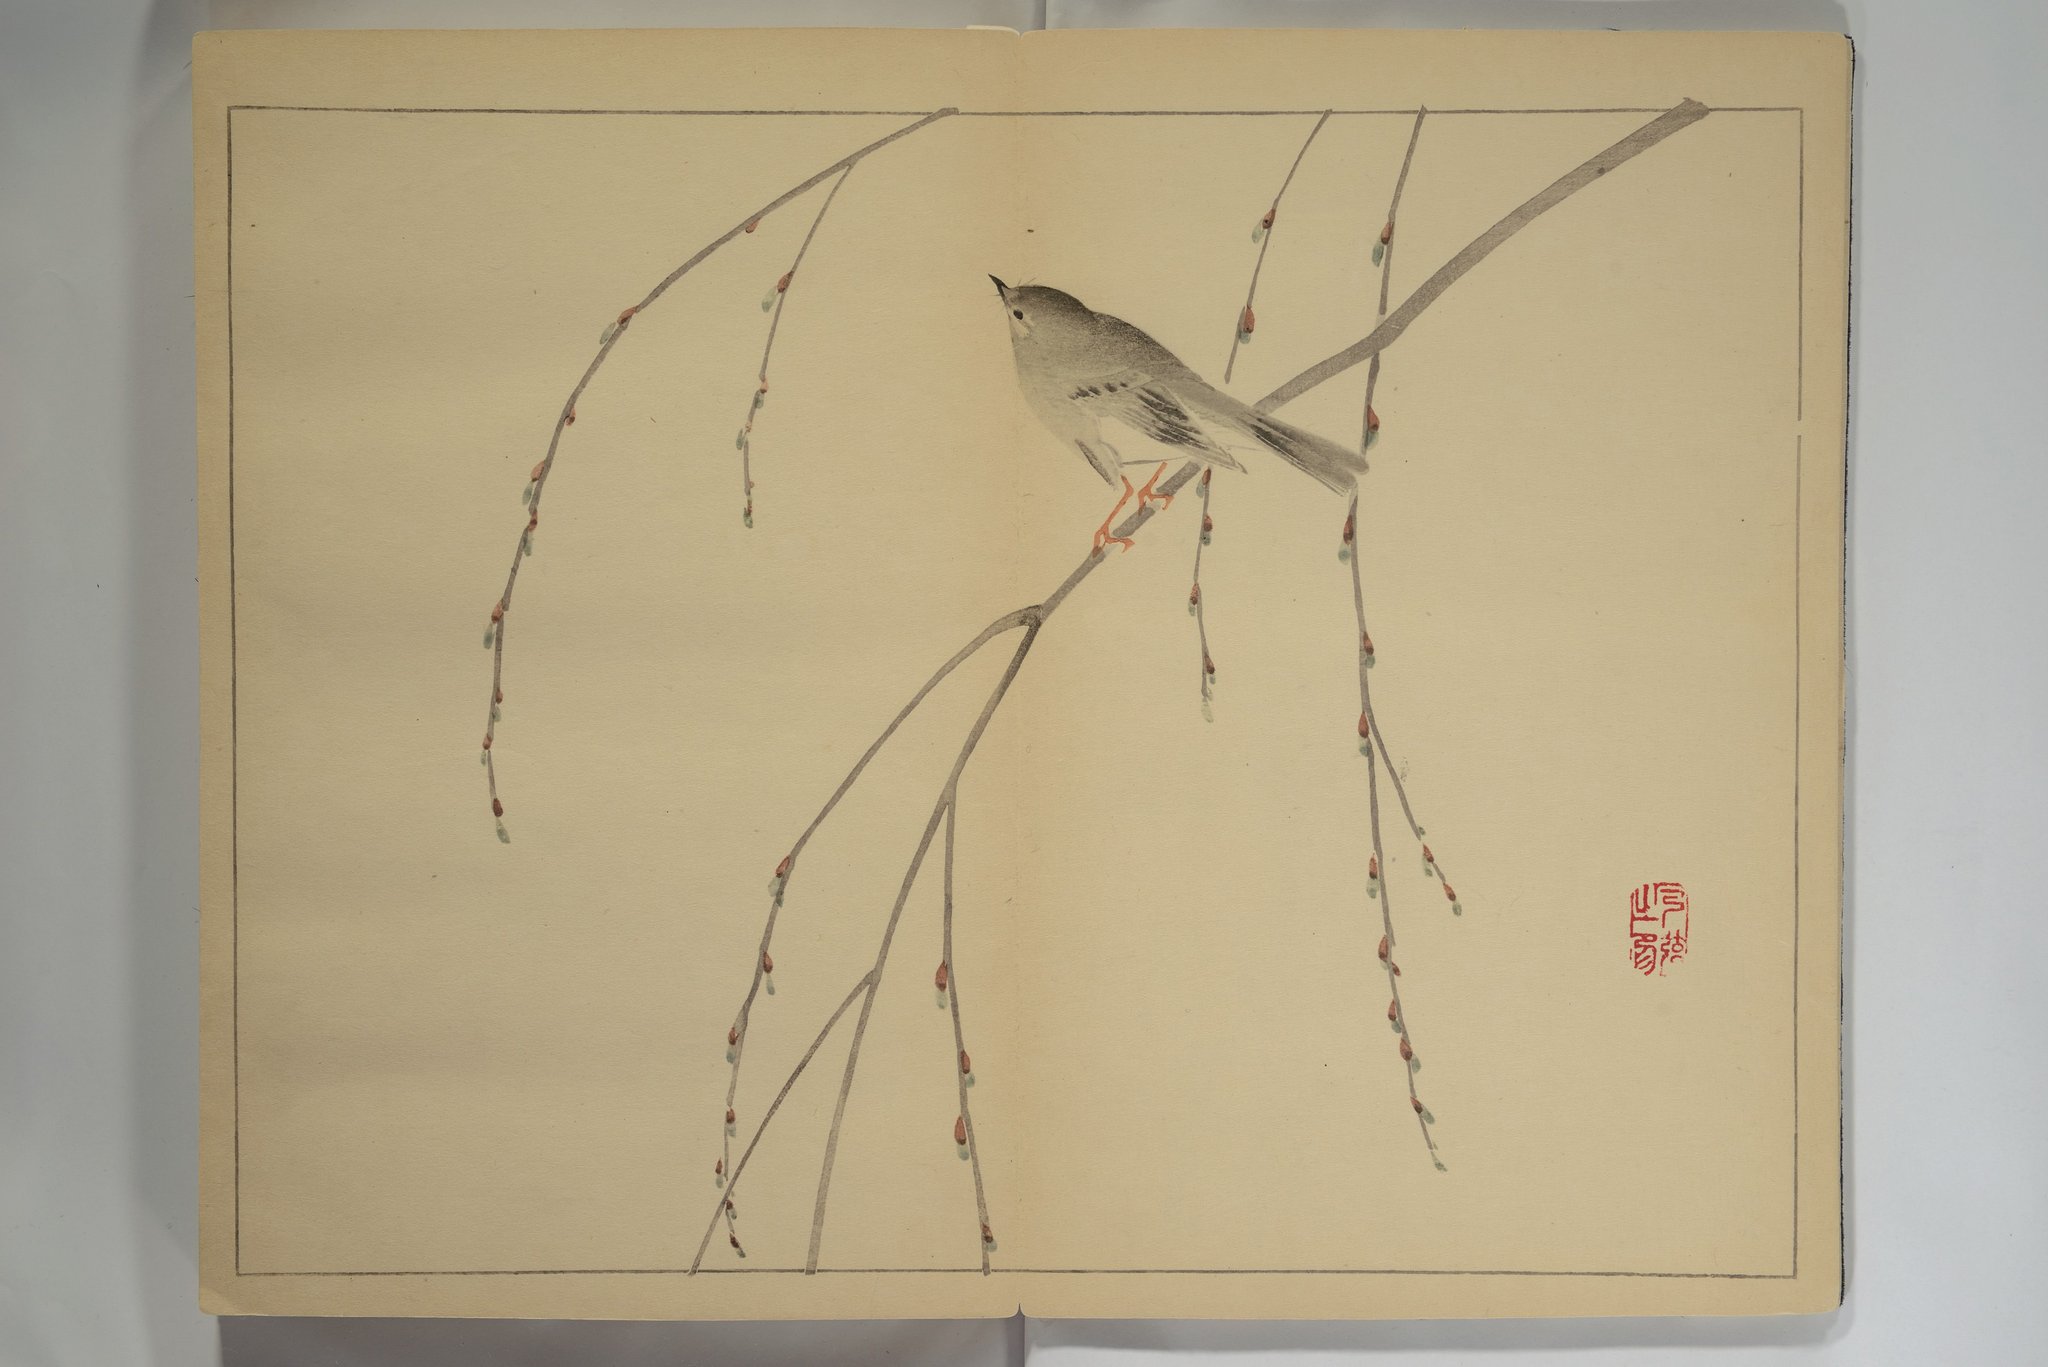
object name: illustrated book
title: Kan'ei Picture Album (Kan'ei gafu 完瑛画譜)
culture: japanese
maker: nishiyama ken 西山謙一郎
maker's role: artist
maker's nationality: japanese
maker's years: 1833-1897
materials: ink, paper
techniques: woodblock print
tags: birds,plants